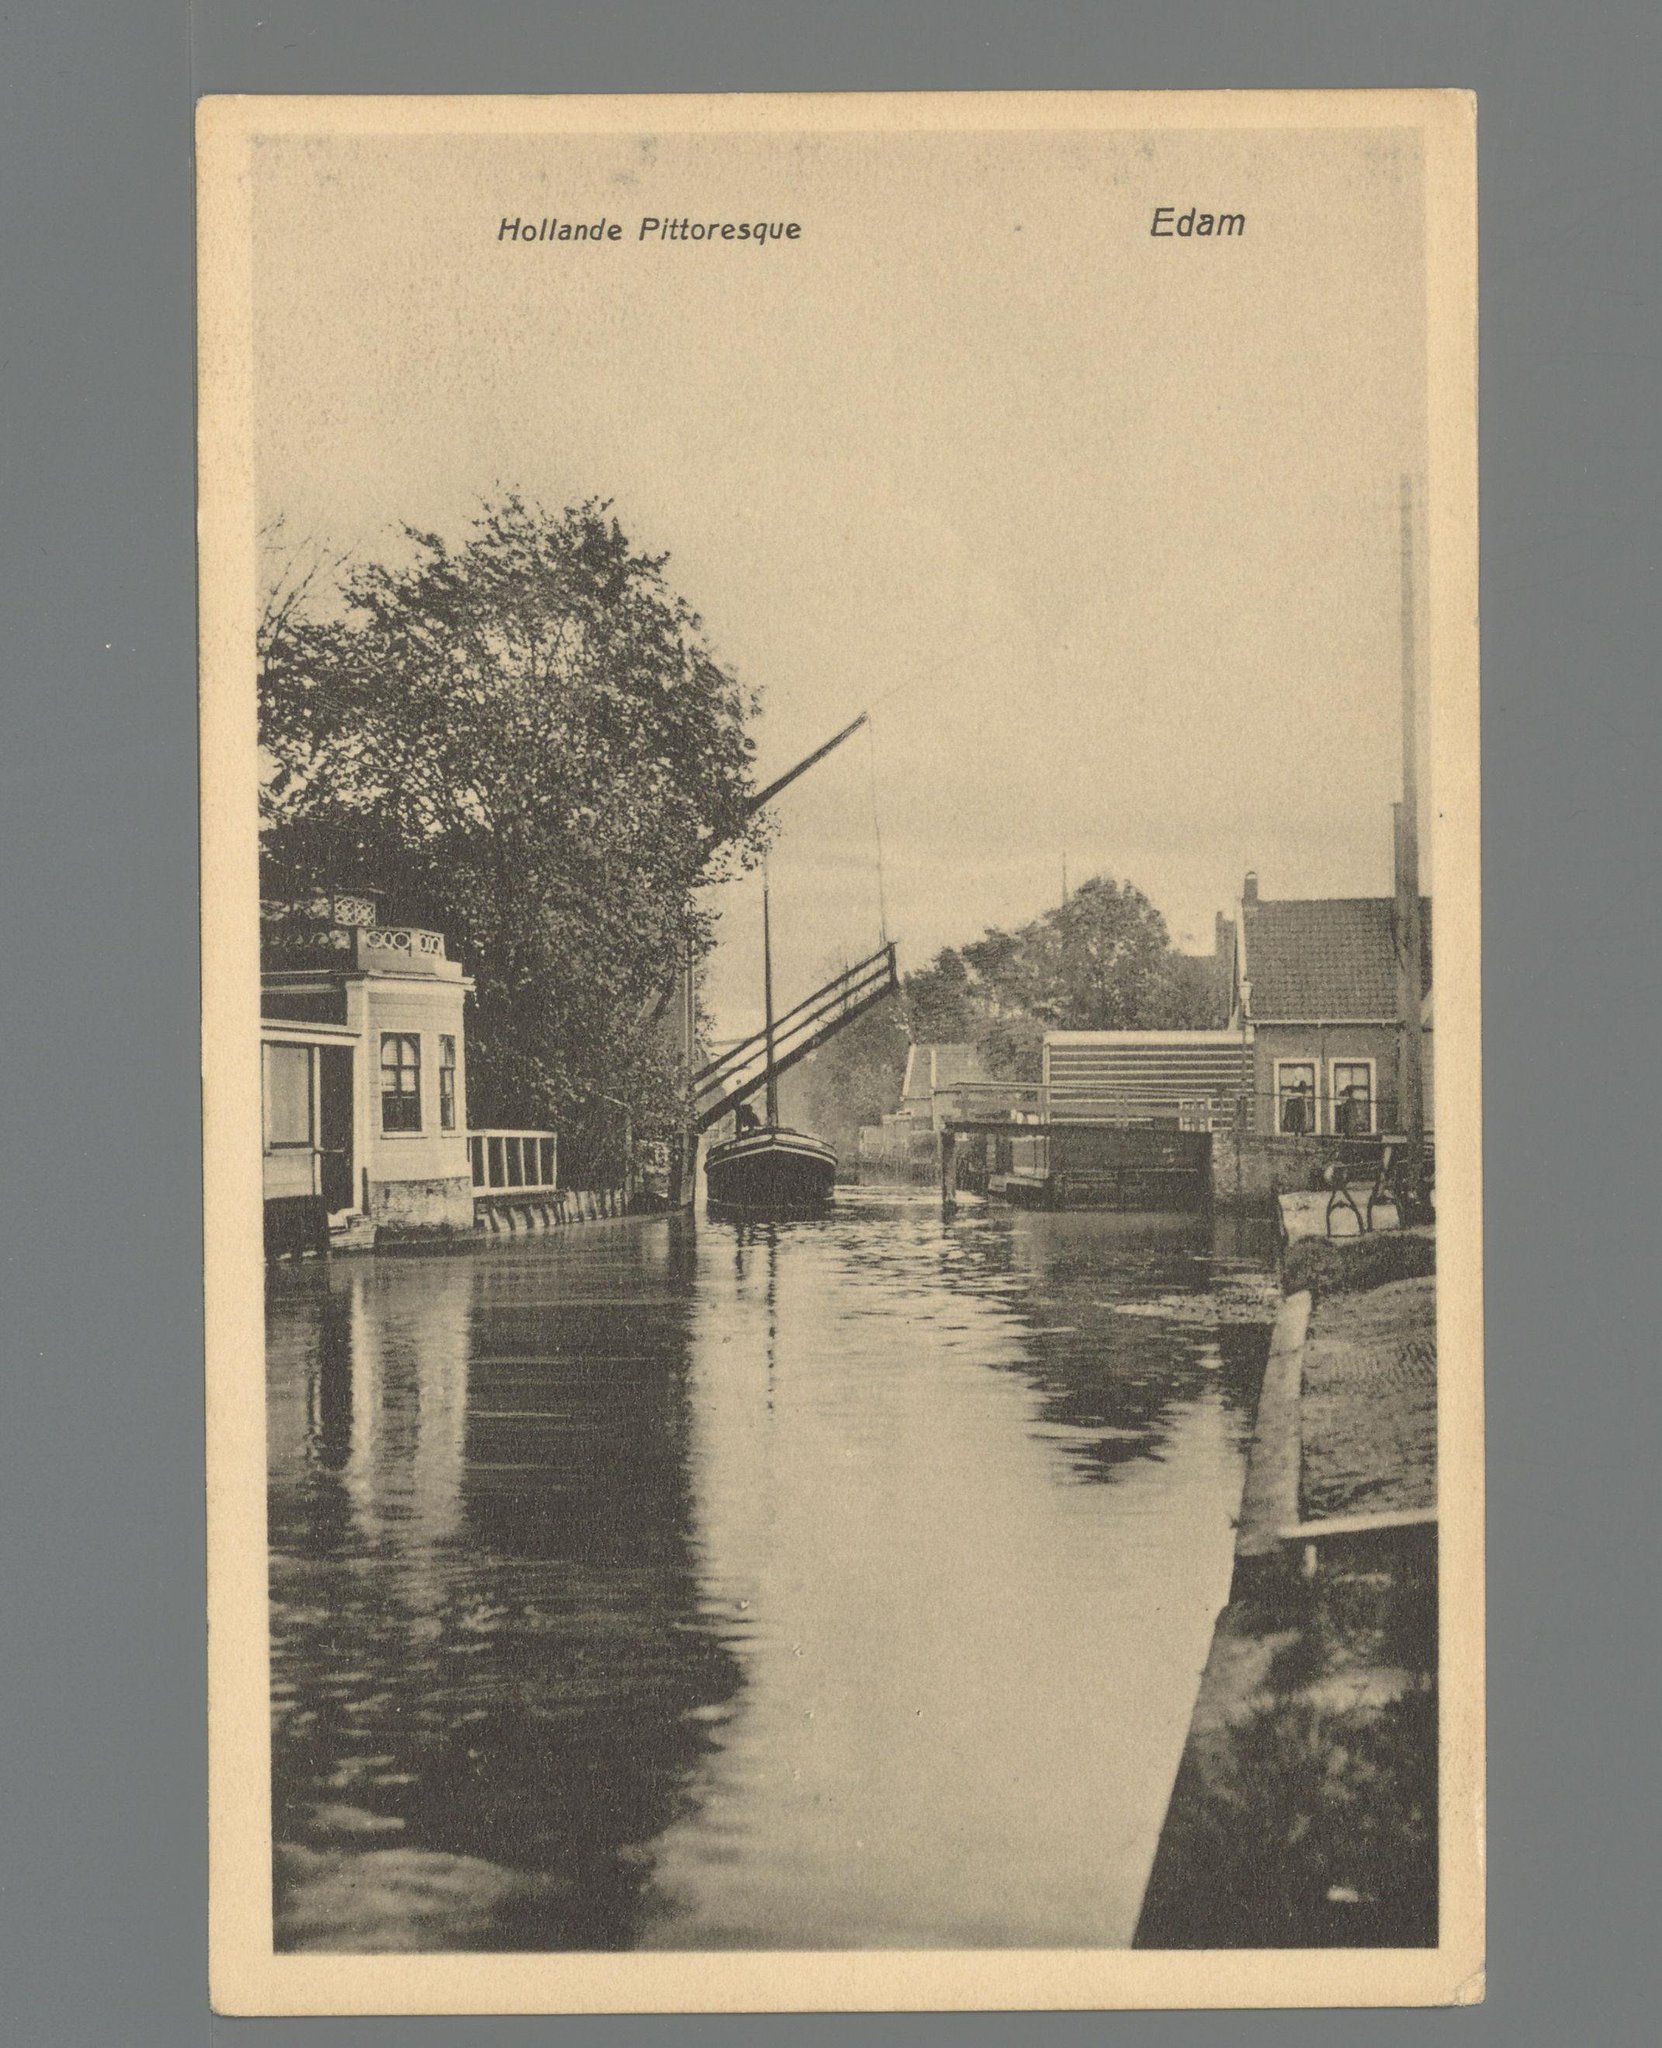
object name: photomechanical print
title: Edam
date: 1913-1943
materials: cardboard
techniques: photograph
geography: amsterdam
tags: city-view, and landscape with man-made constructions, sailing-ship, sailing-boat, bridge in city across river, canal, etc.